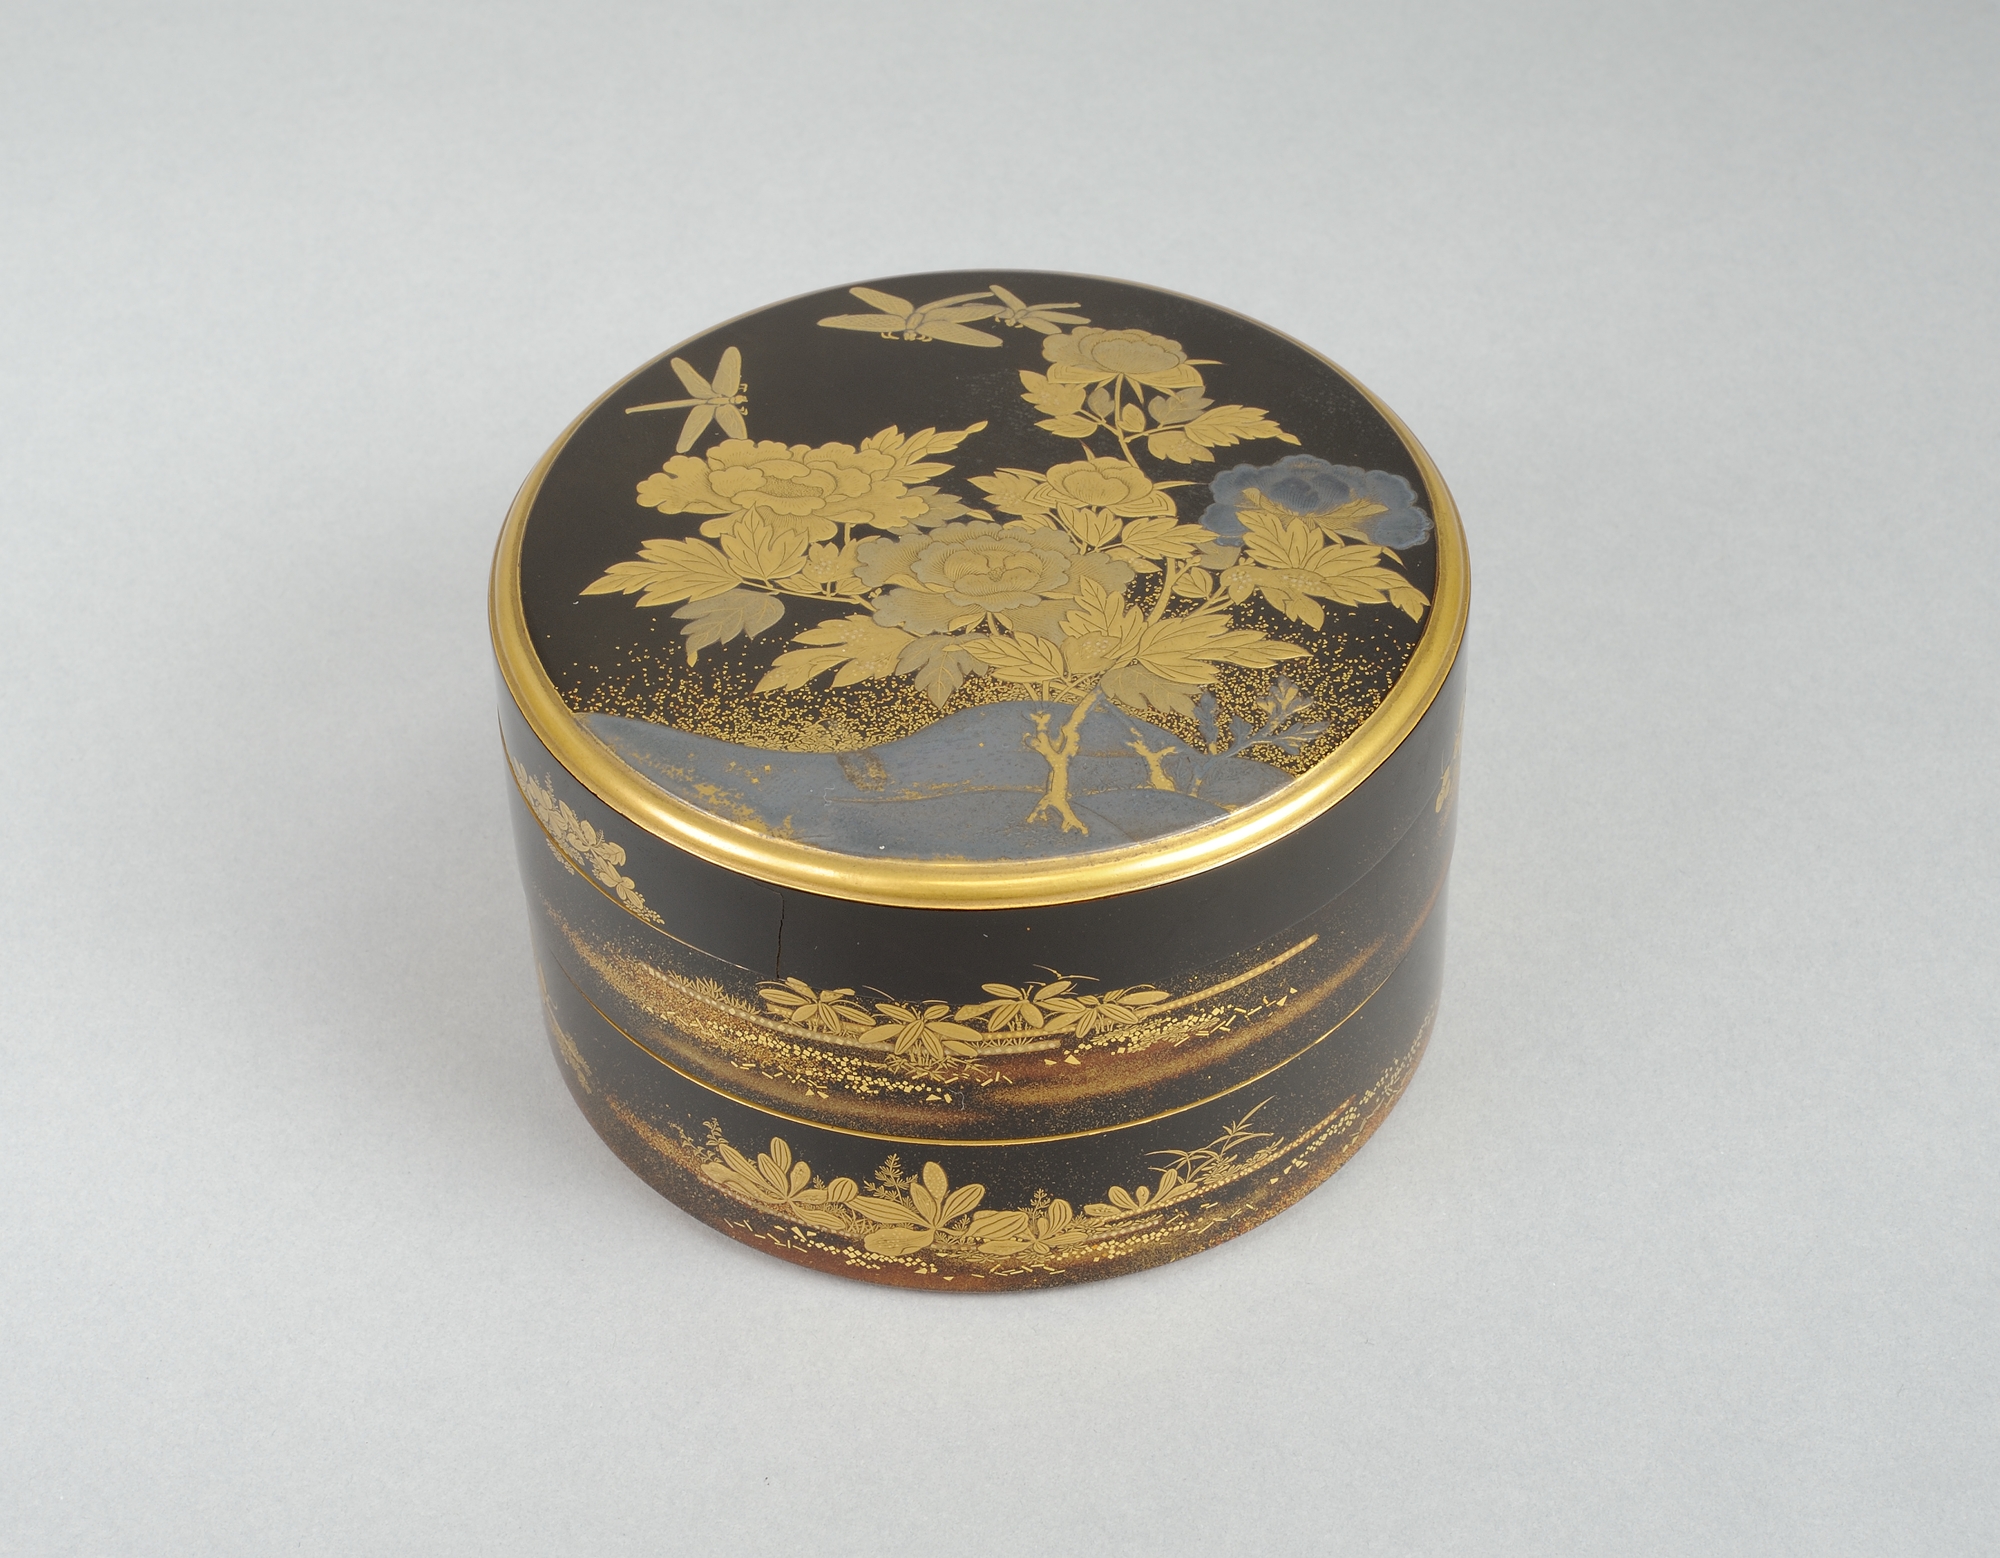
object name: incense box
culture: japanese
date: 1834-1866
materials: lacquer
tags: flowers,leaves